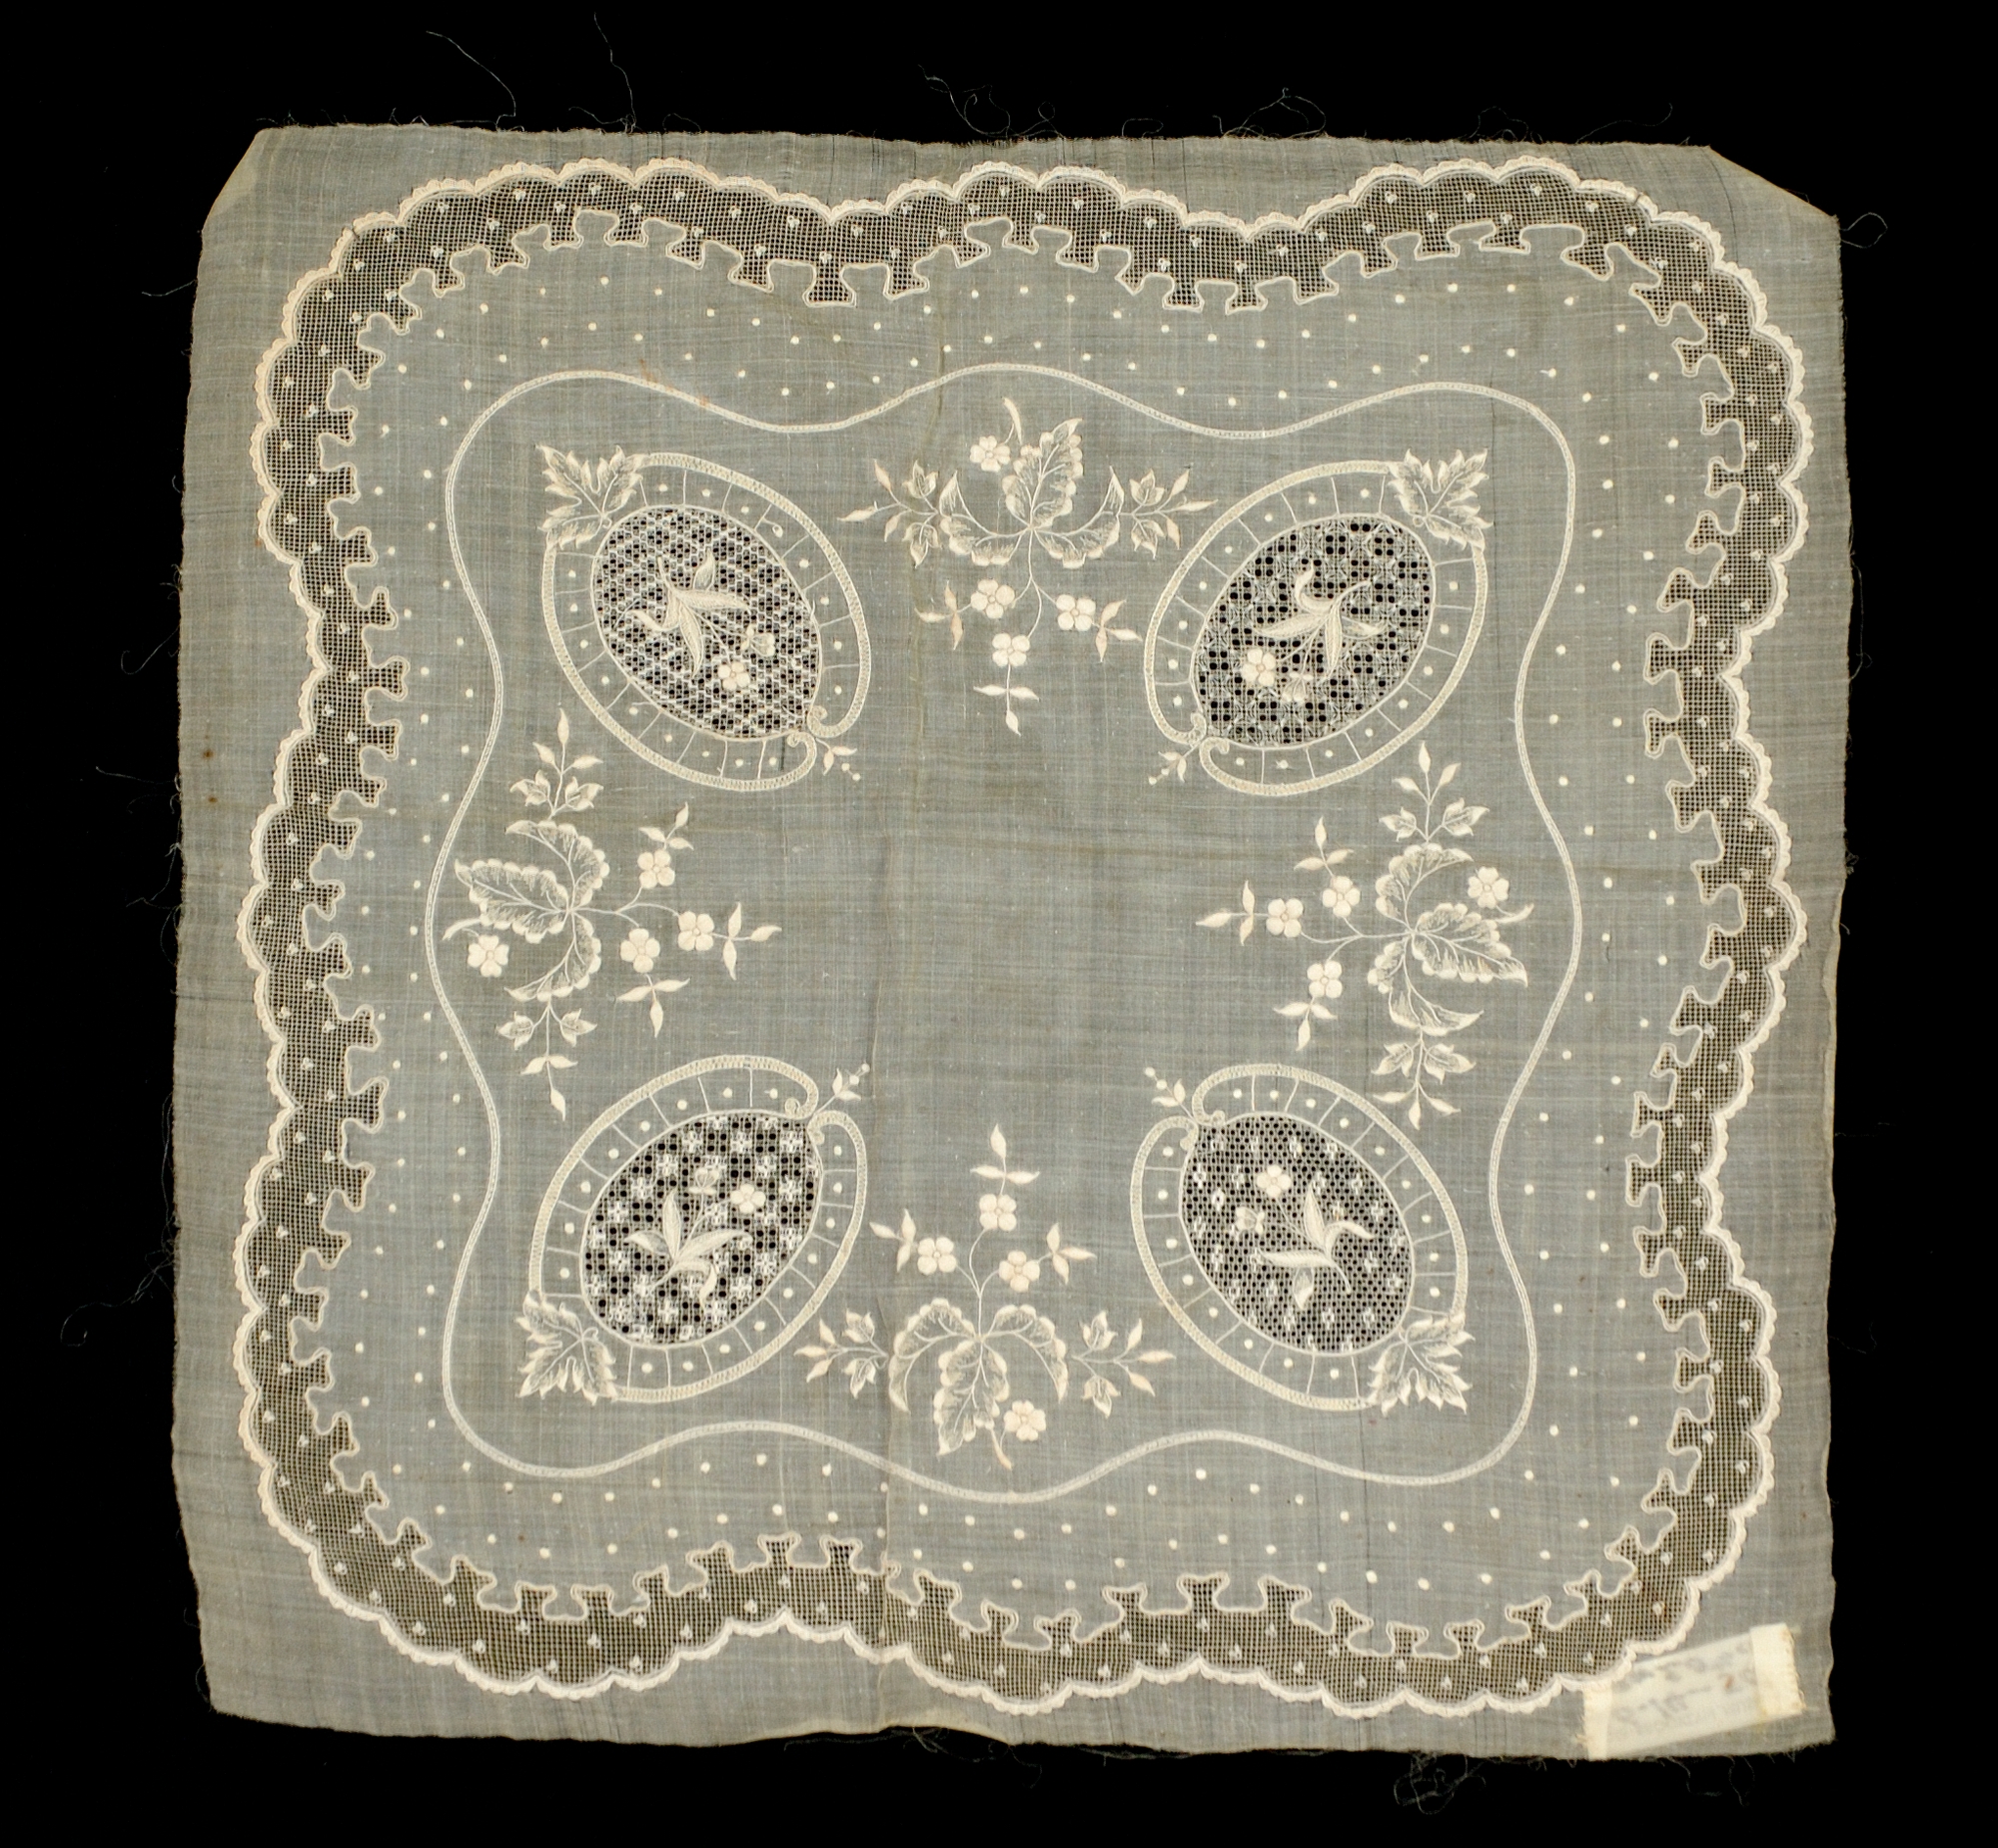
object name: handkerchief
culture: philippine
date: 1876-1900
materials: fiber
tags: flowers